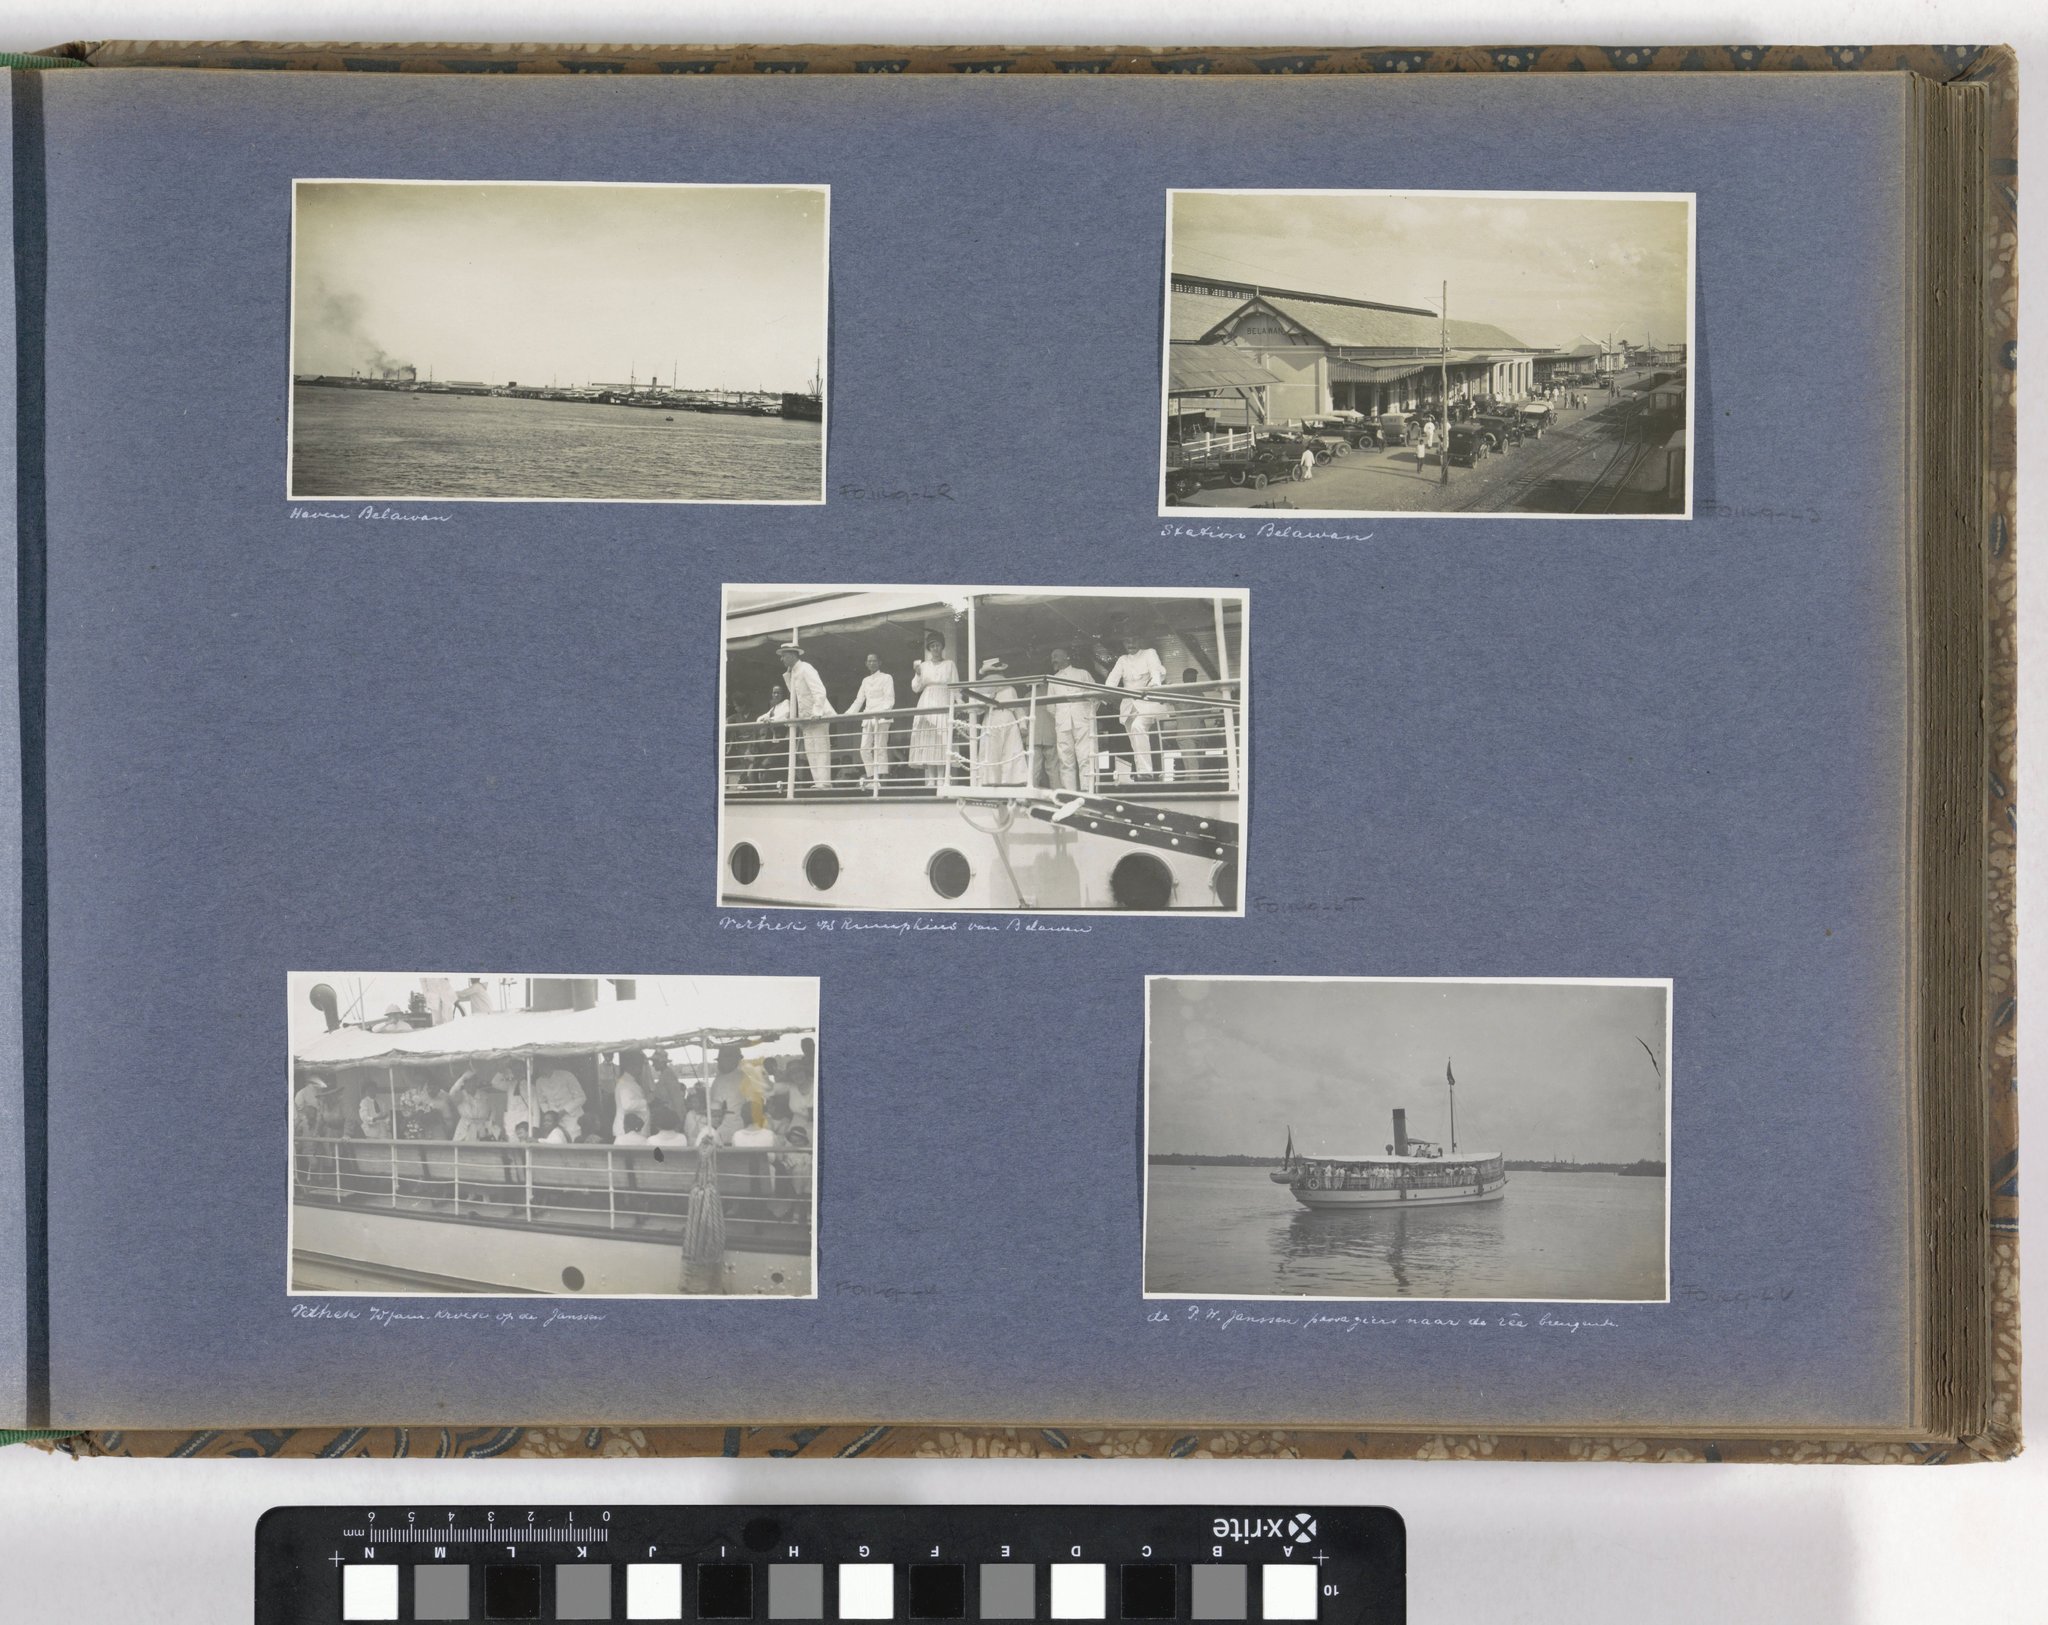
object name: album leaf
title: Passagiers aan boord van ss. Rumphius bij vertrek uit de haven van Belawan op Sumatra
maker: Anonymous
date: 1900-1920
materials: paper, photographic support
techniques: gelatin silver print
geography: belawan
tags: passengers ~ ship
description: Onderdeel van reisalbum met foto's van bedrijvigheid en bezienswaardigheden op Sumatra en Java en van de reis naar en van Nederlands-Indië.